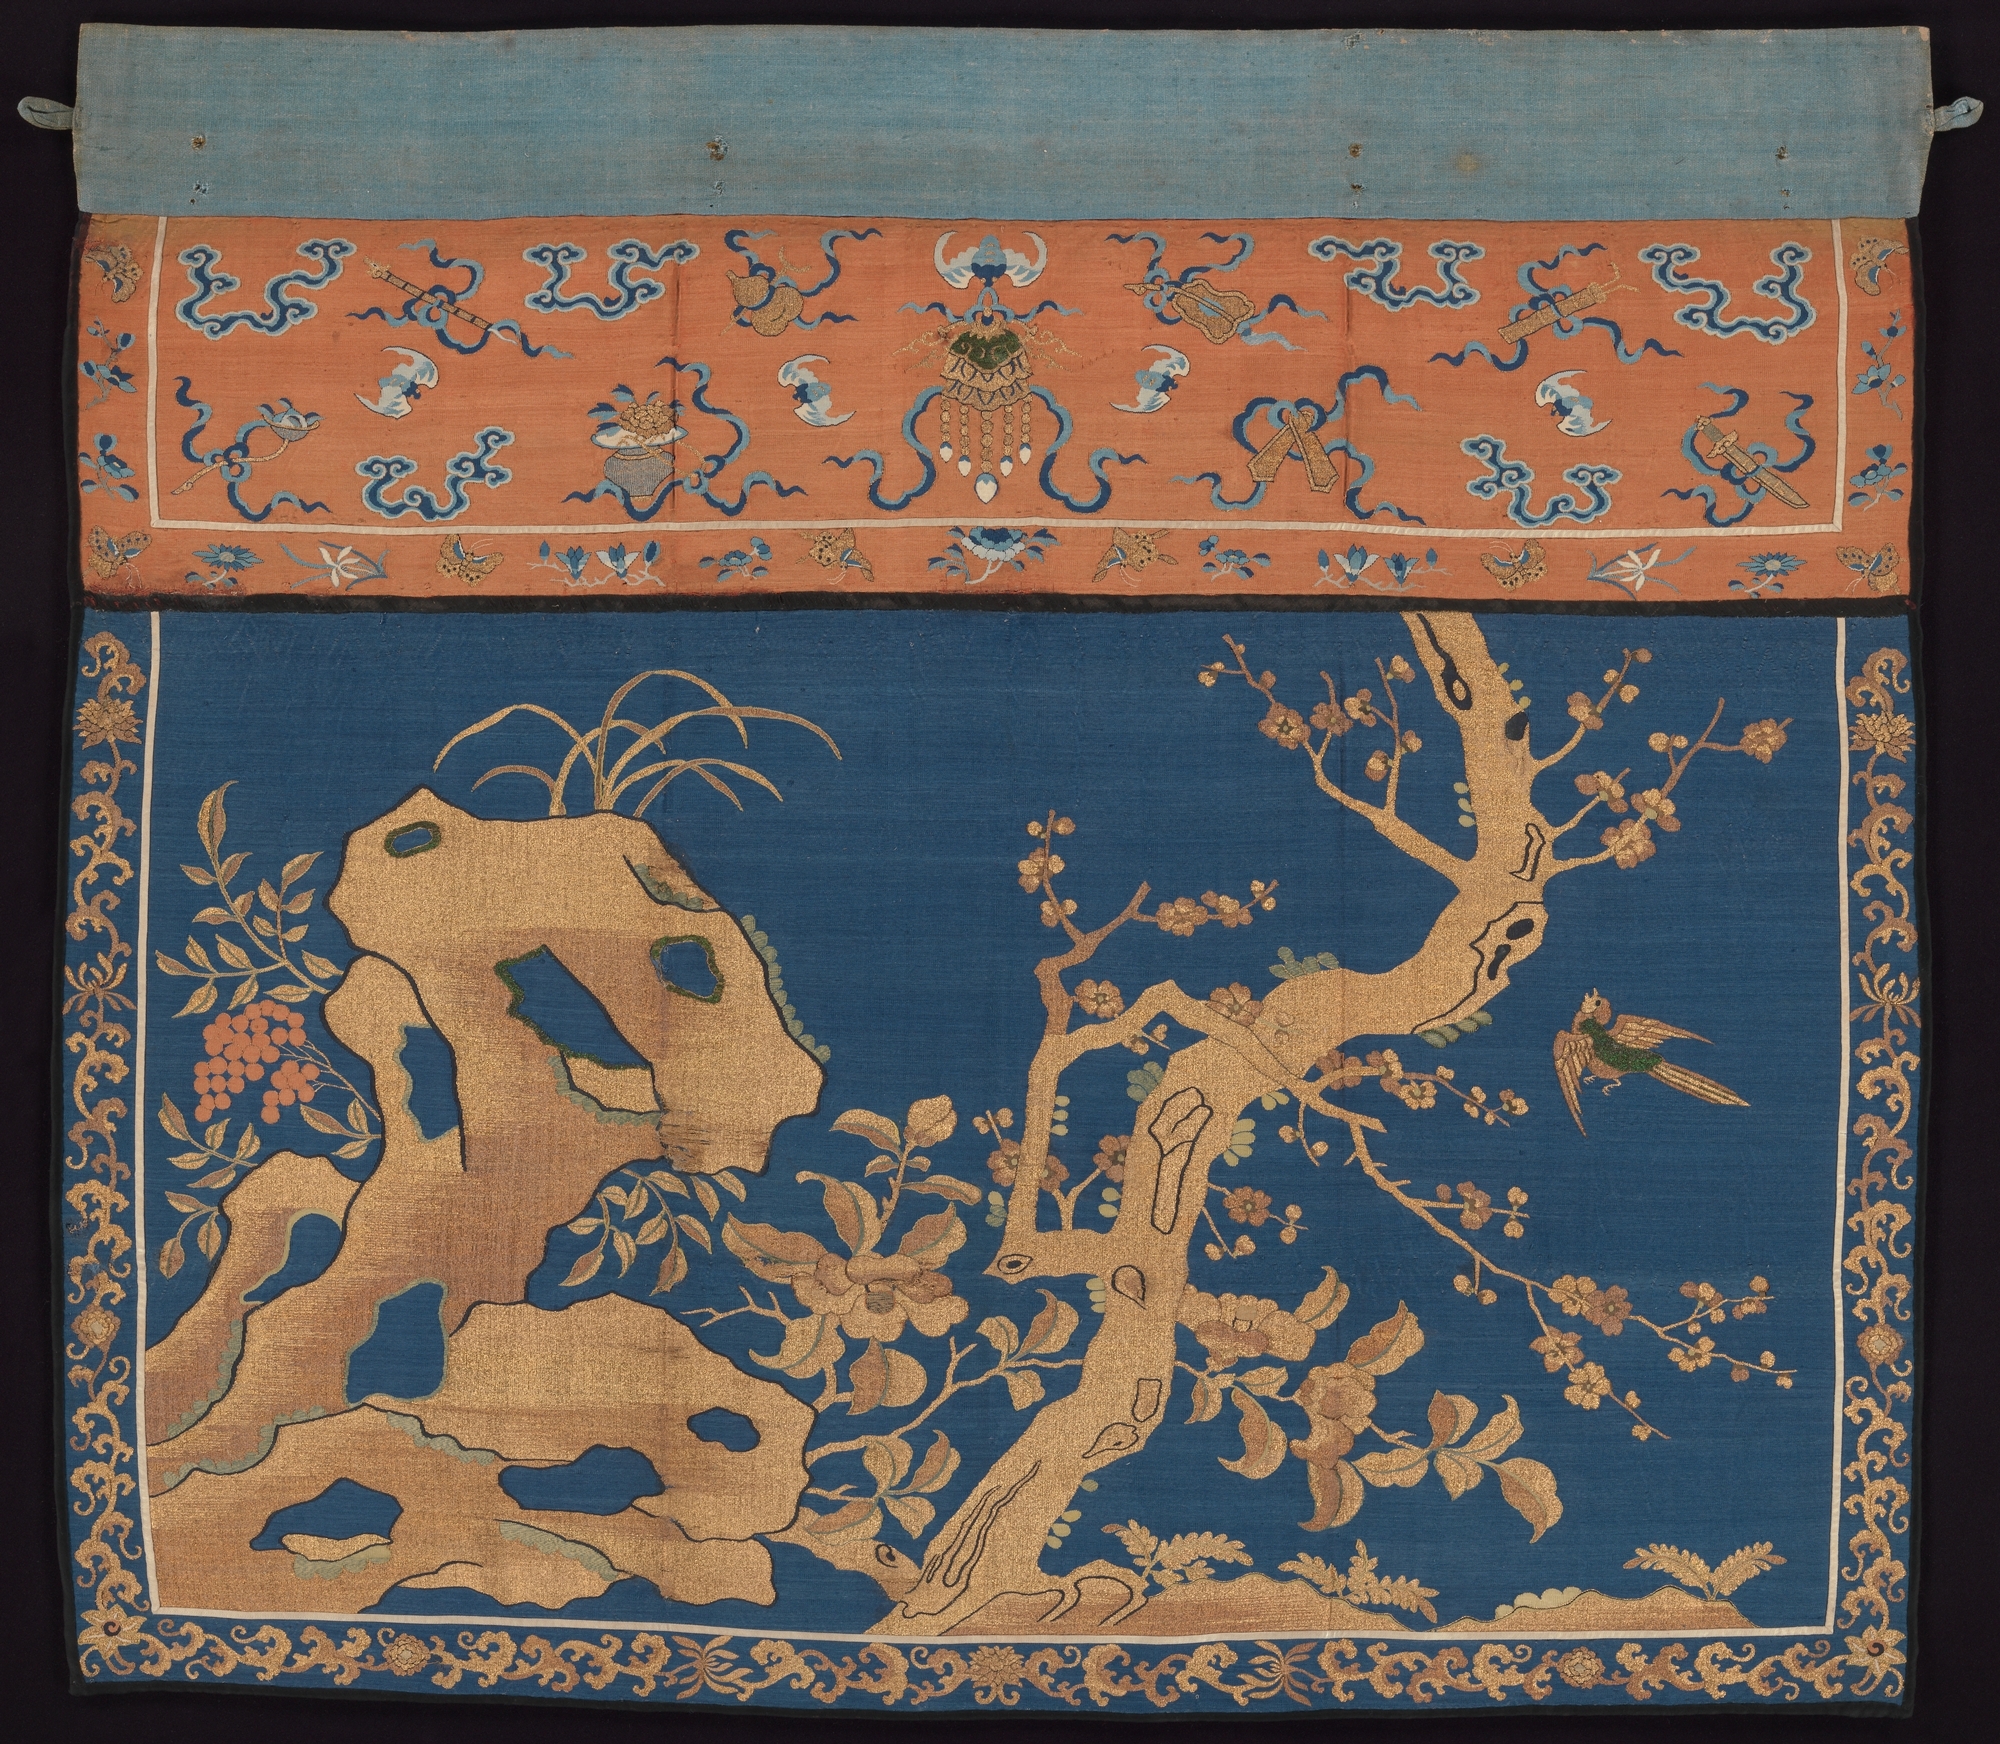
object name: valance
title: Table Valance with Winter Garden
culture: chinese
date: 1701-1800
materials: feather, metal thread, silk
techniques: tapestry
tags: birds,flowers,trees